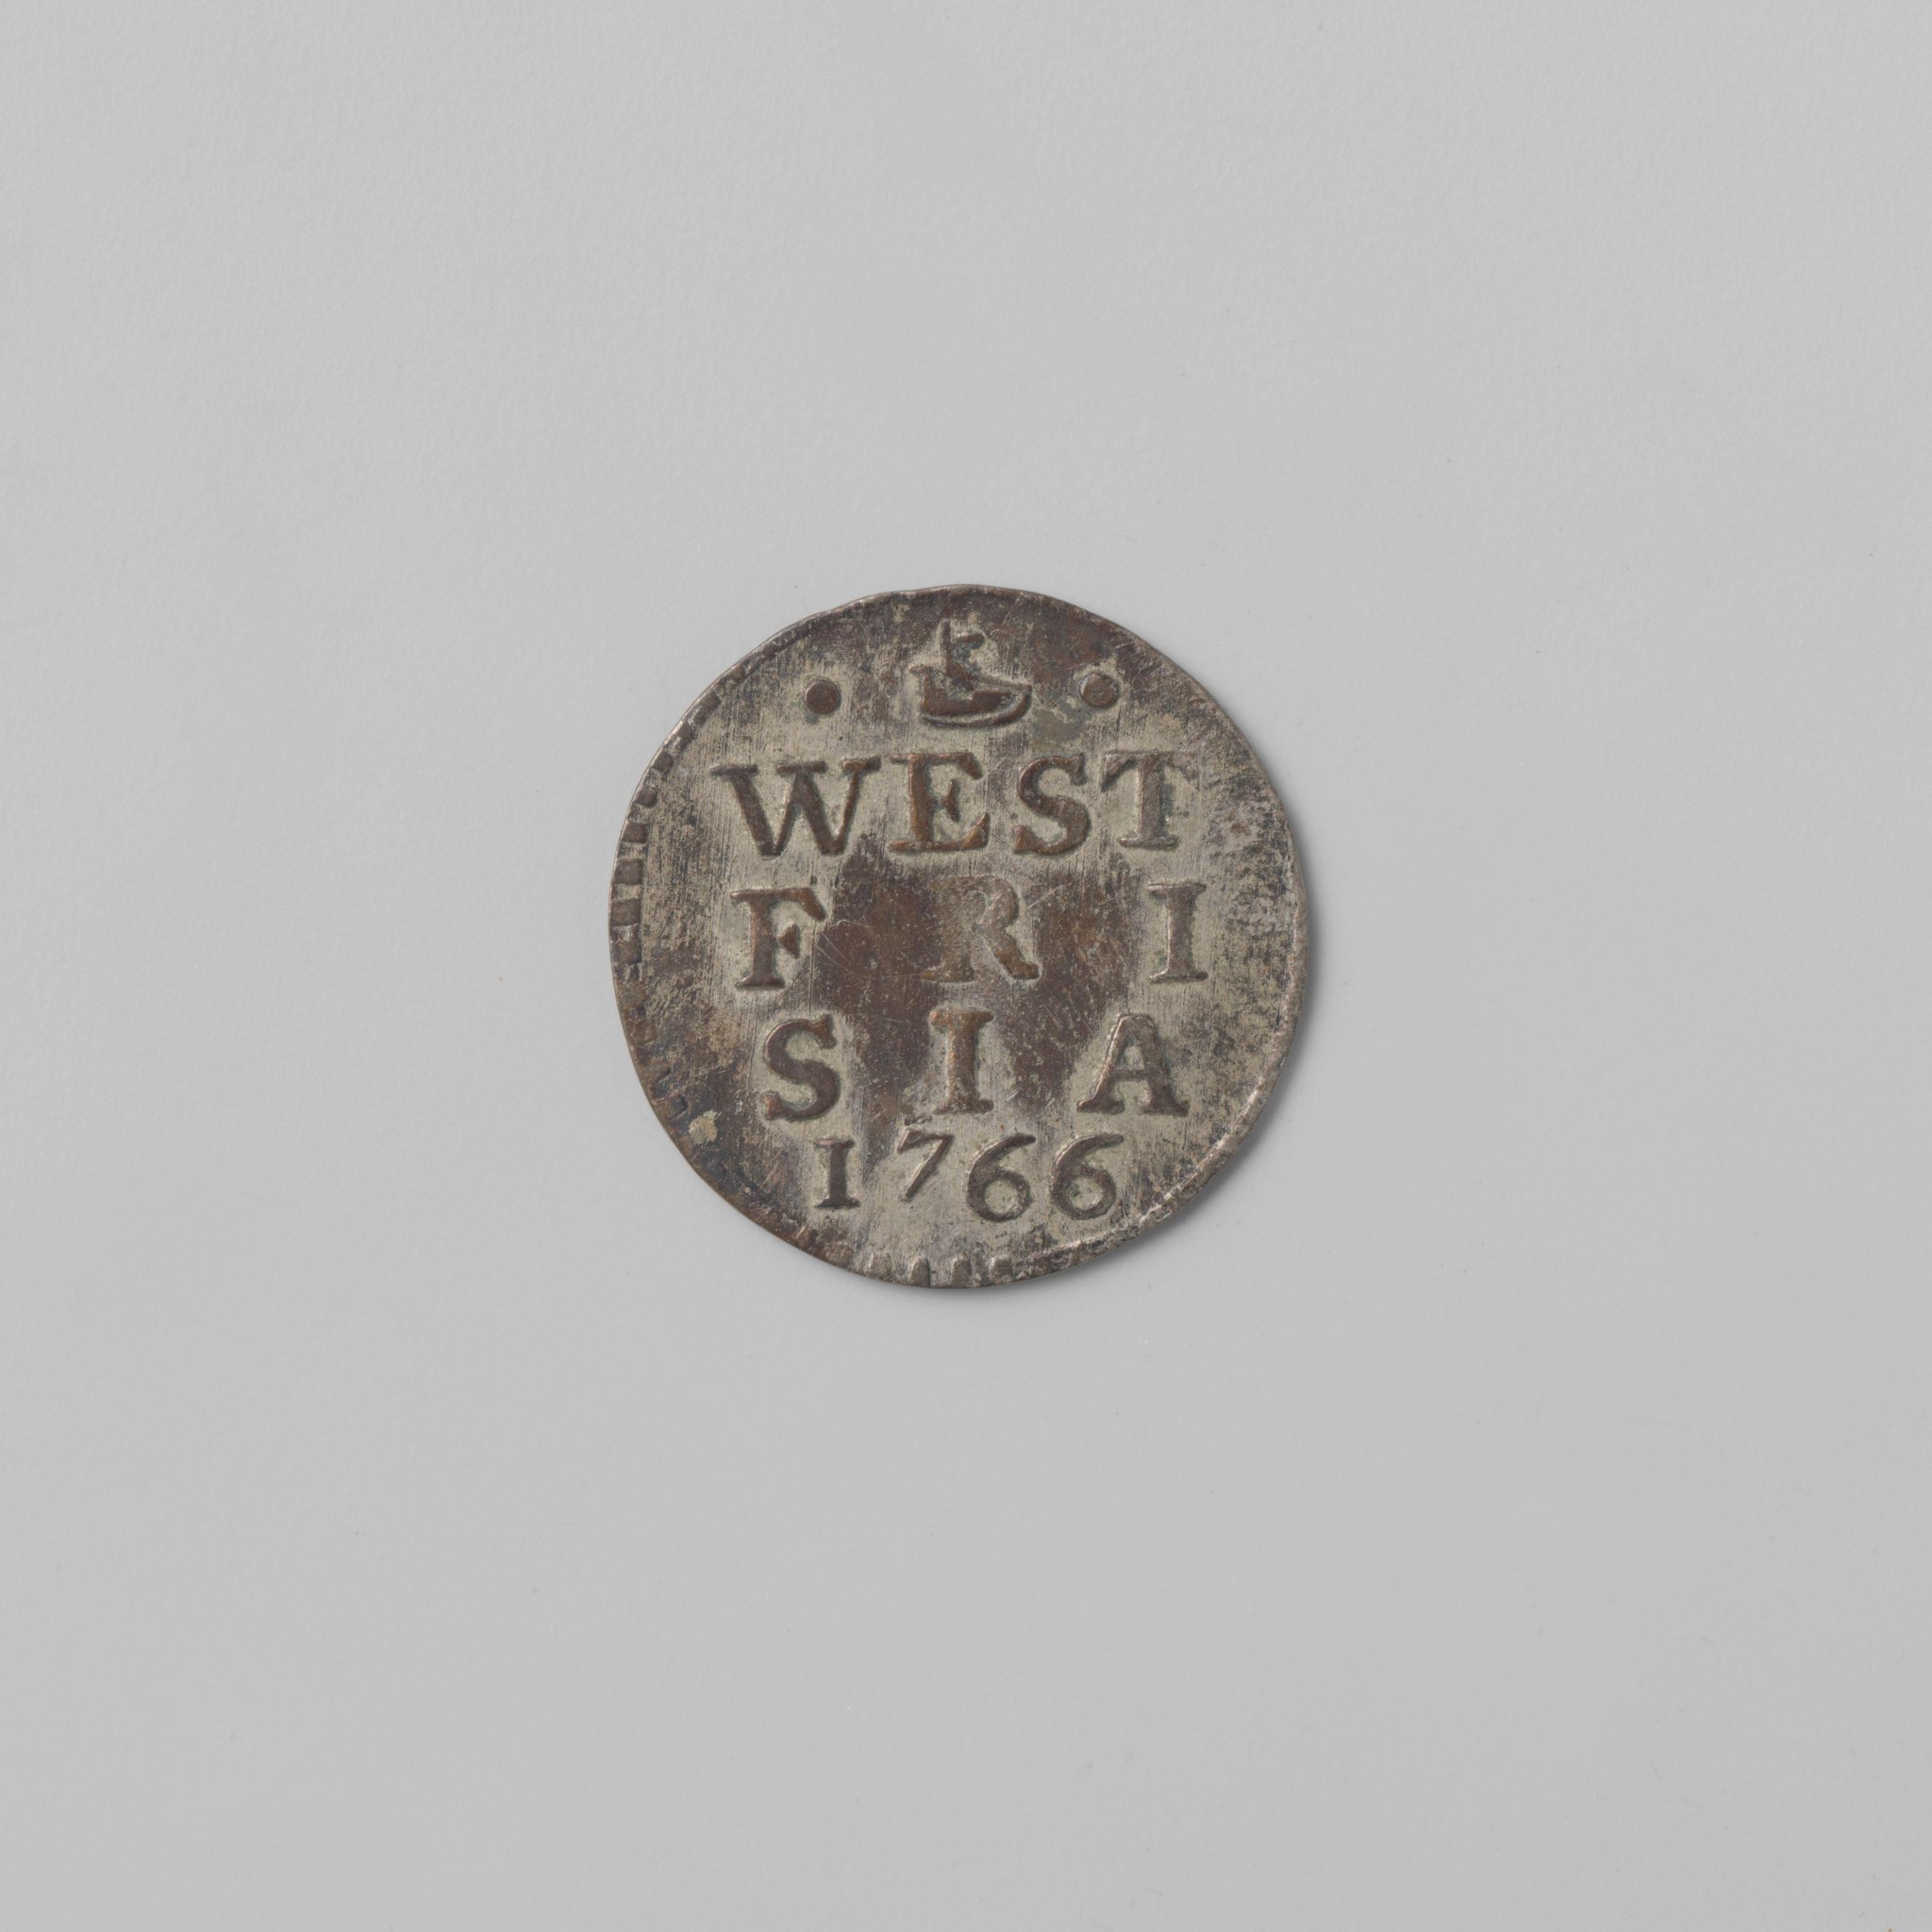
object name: coin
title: West-Friesland, bezemstuiver, 1766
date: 1766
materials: silver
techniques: striking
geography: west frisia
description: Zilveren munt. Voorzijde: binnen een lauwerkrans tussen waarde-aanduiding 1 S pijlenbundel. Keerzijde: opschrift in drie regels. Daarboven muntmeesterteken tussen twee punten, daaronder jaartal.